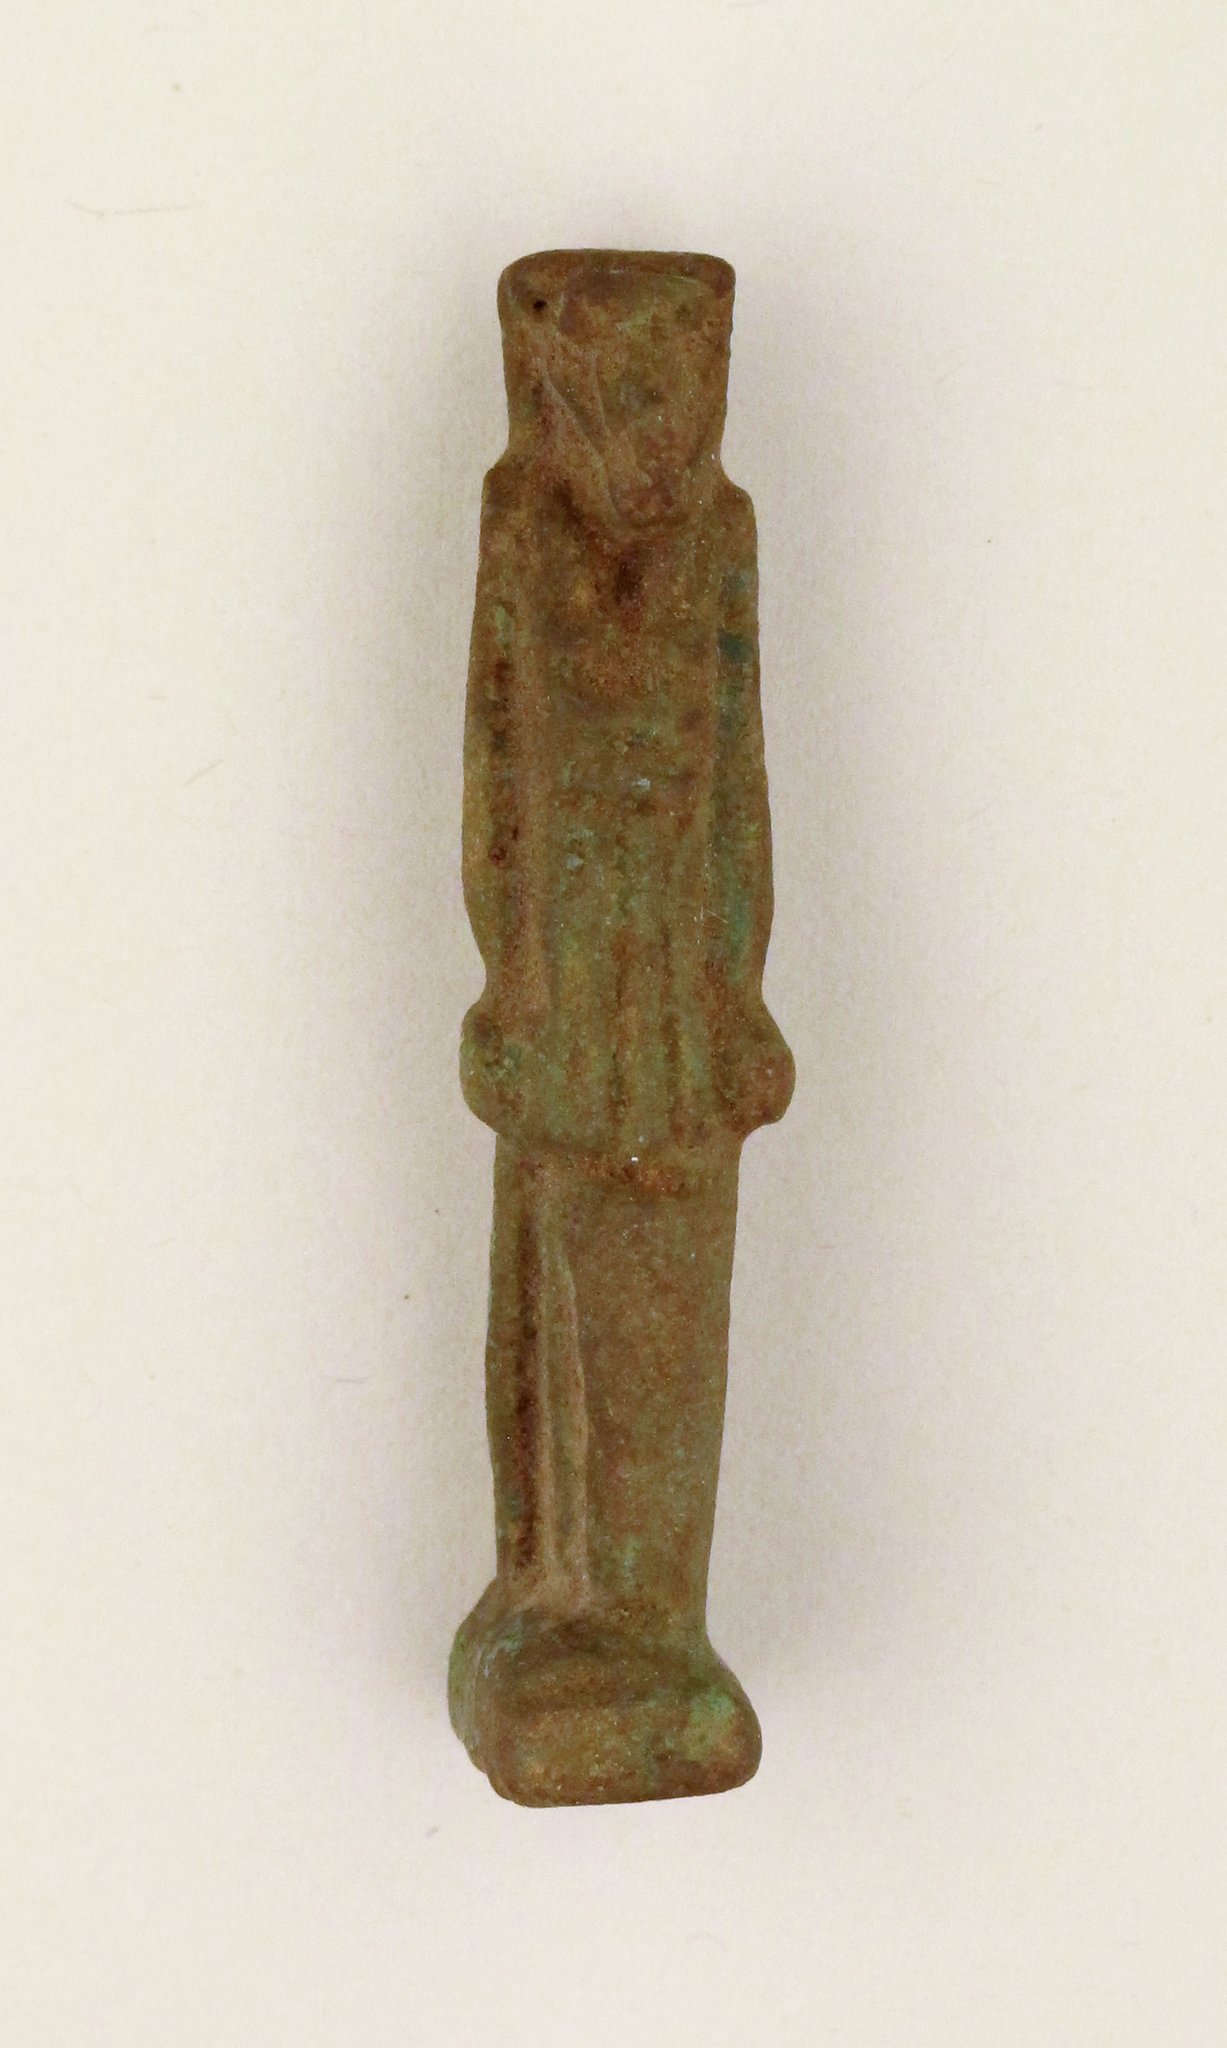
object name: amulet, khnum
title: Faience amulet of an animal-headed god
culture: egyptian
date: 664-334 BCE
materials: faience